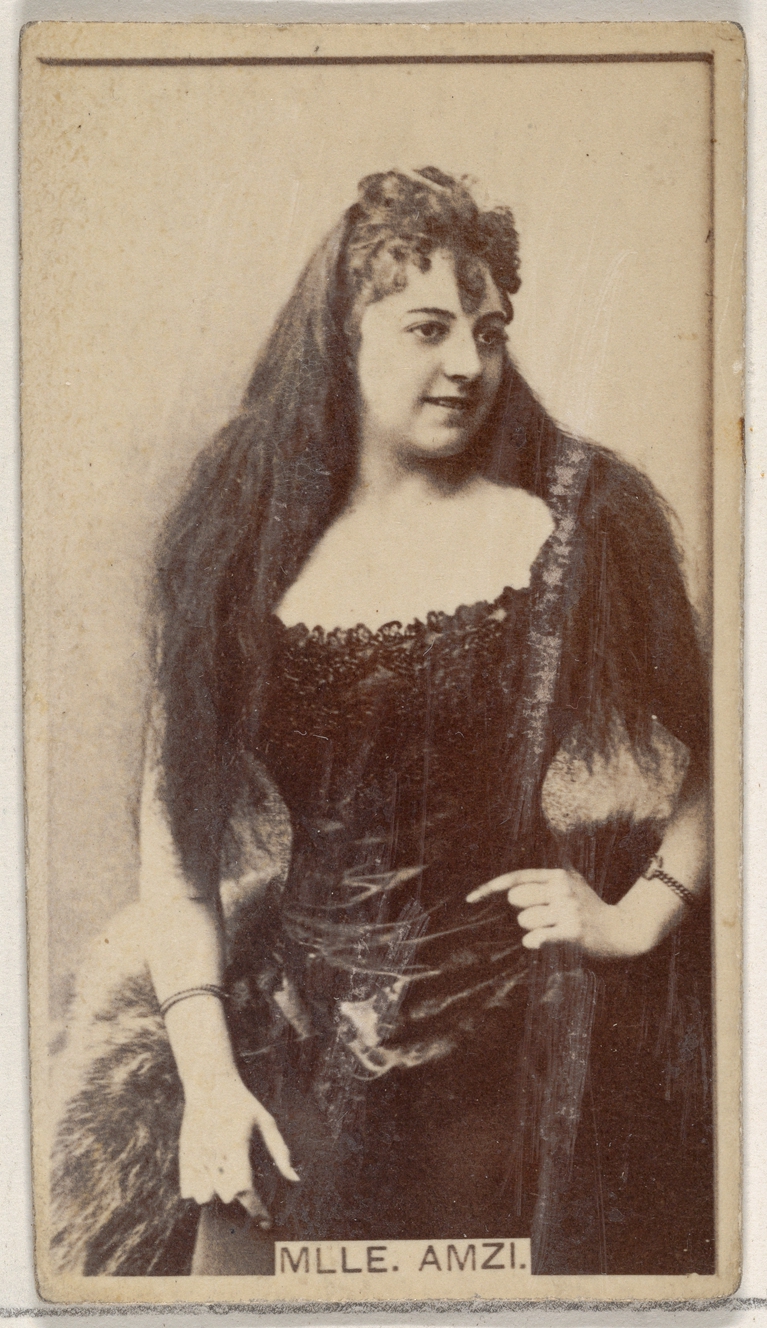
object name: photograph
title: Mlle. Amzi, from the Actors and Actresses series (N45, Type 8) for Virginia Brights Cigarettes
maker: allen & ginter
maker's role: publisher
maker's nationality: american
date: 1888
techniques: albumen silver print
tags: portraits,women,actresses